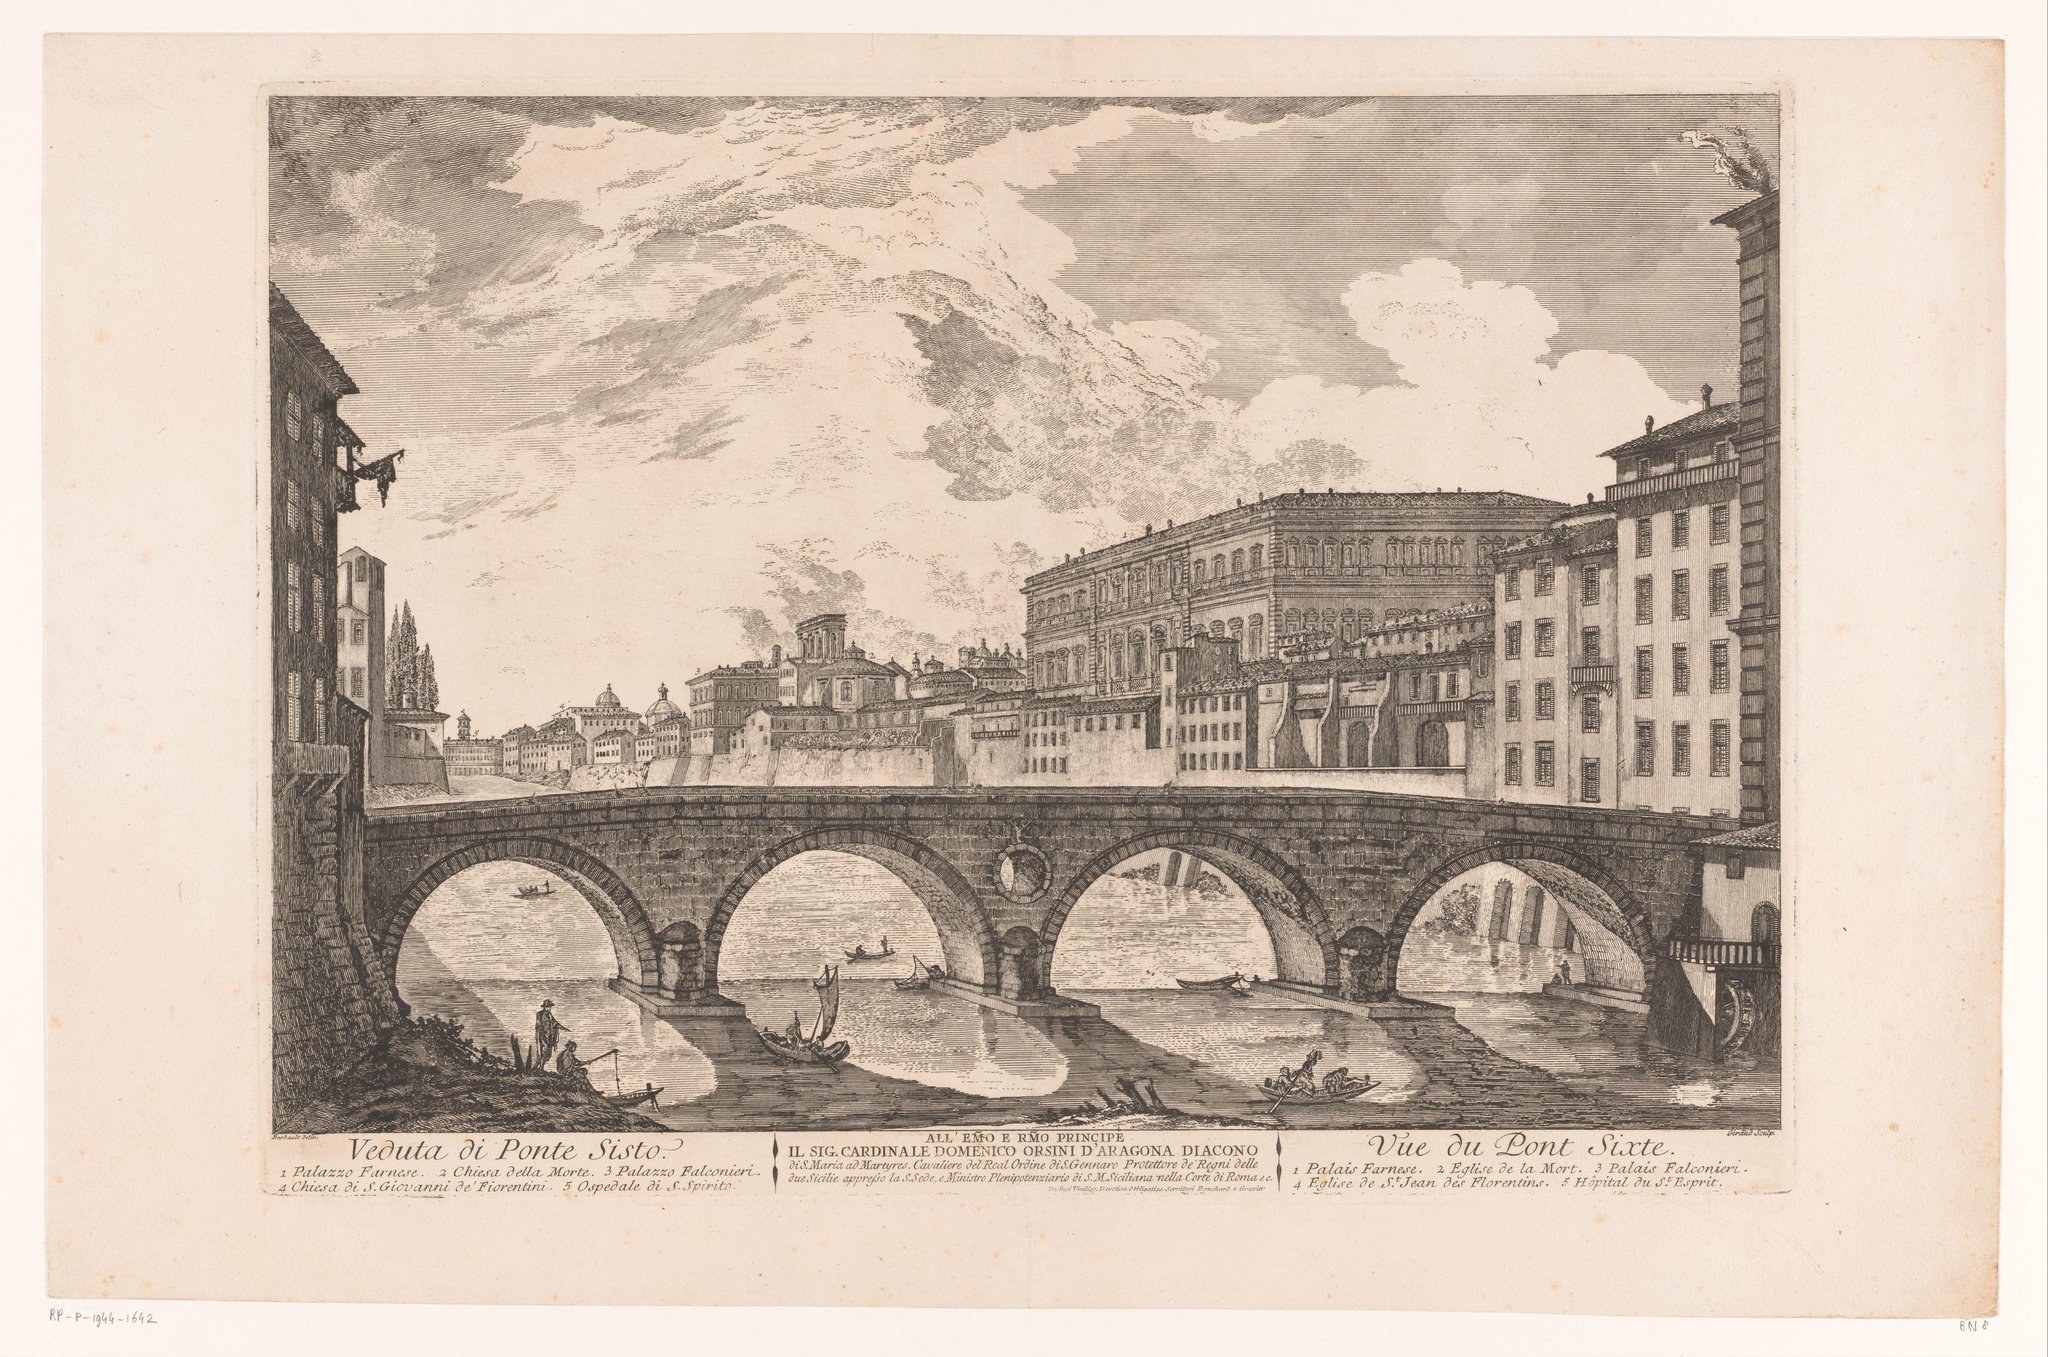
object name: book illustration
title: Vue du Pont Sixte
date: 1763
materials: paper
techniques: etching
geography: rome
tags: city-view in general; 'veduta', hôtel, i.e. small palace in city, bridge in city across river, canal, etc.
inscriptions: collector's mark: Lugt 2228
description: Prent waarschijnlijk gebruikt voor: Barbault, Jean. Les plus beaux édifices de Rome moderne publiés par Jean Barbault peintre (...). Rome: Bouchard et Gravier, 1763.